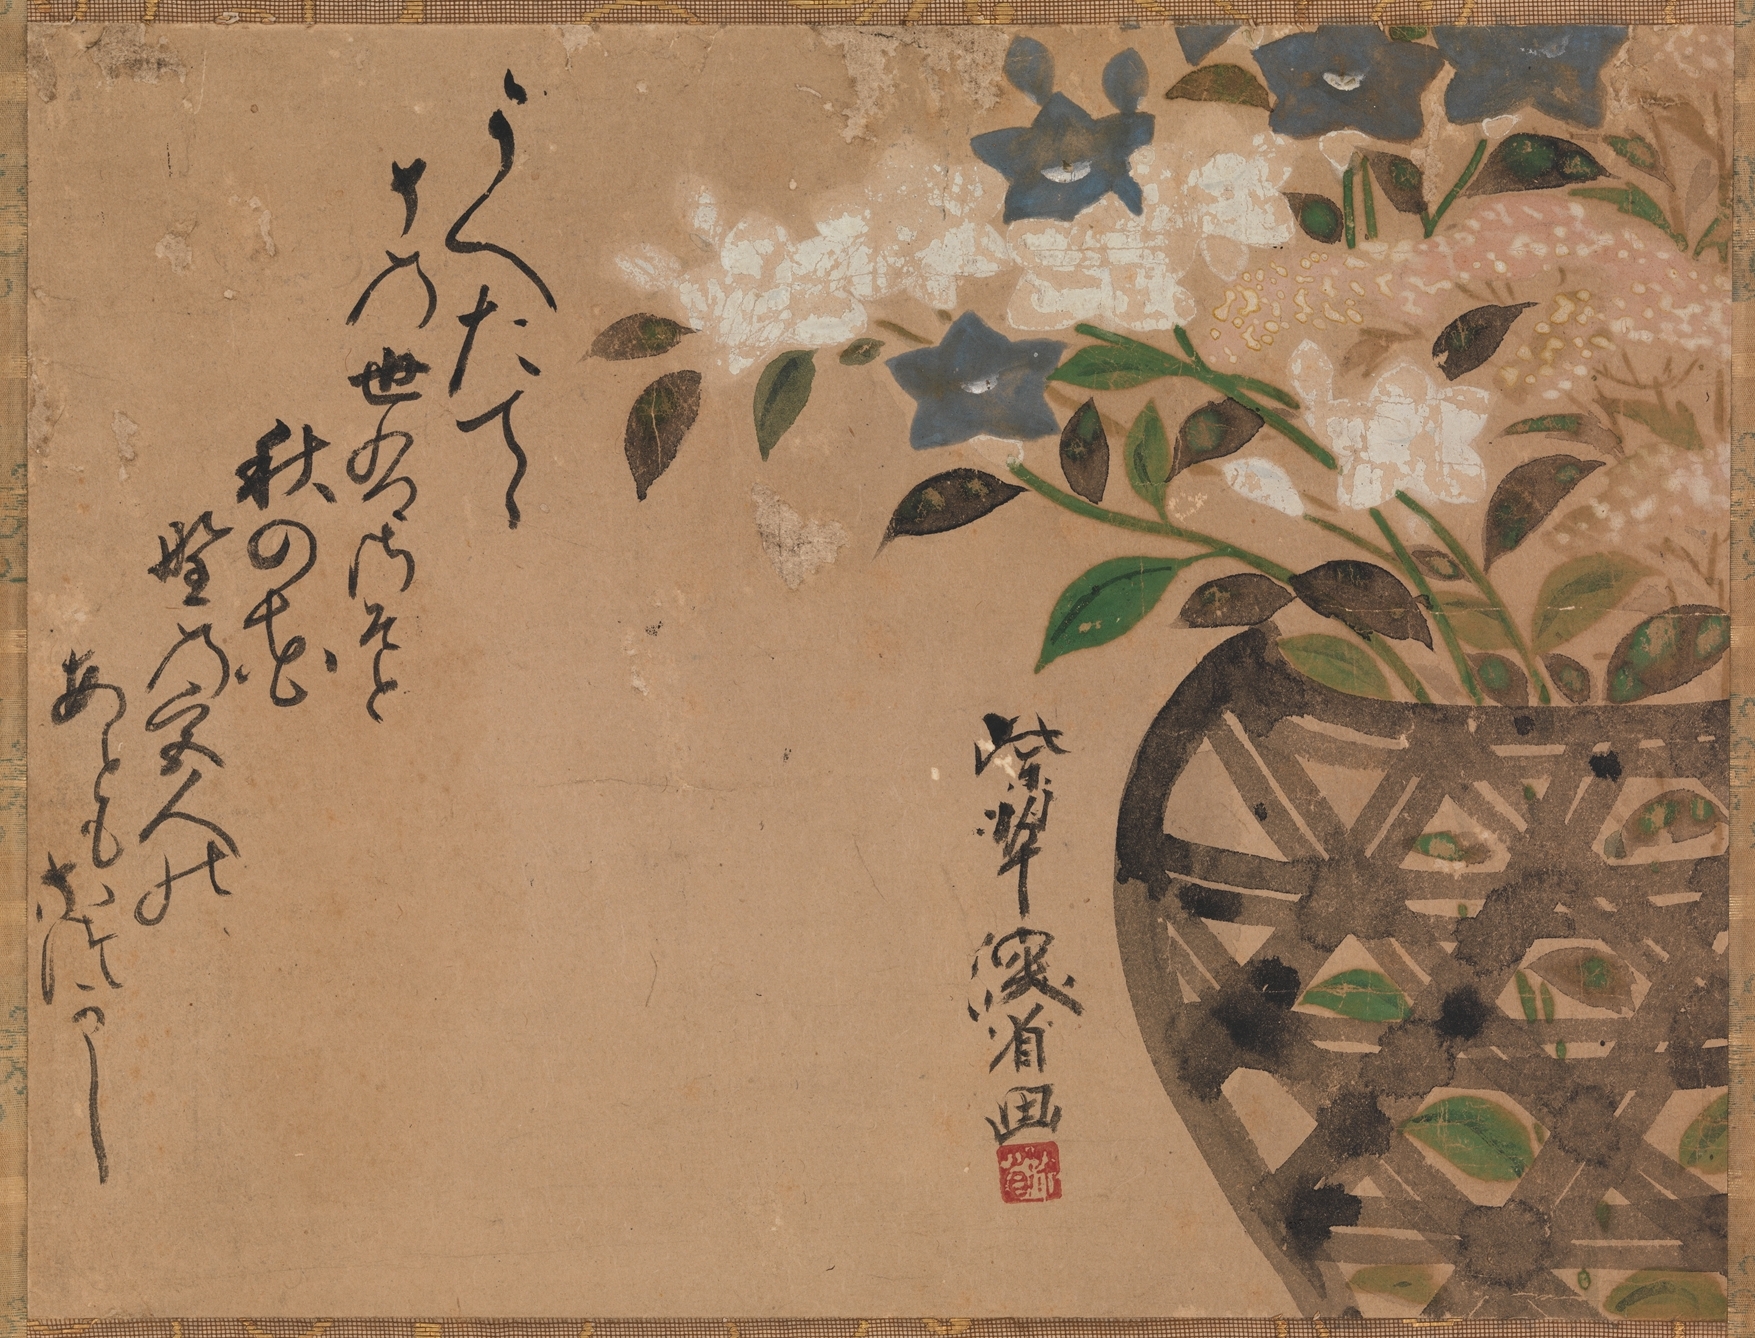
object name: hanging scroll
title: Bellflowers in Basket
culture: japanese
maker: ogata kenzan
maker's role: artist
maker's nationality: japanese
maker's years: 1663-1743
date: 1701-1800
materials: ink, paper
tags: flowers,baskets